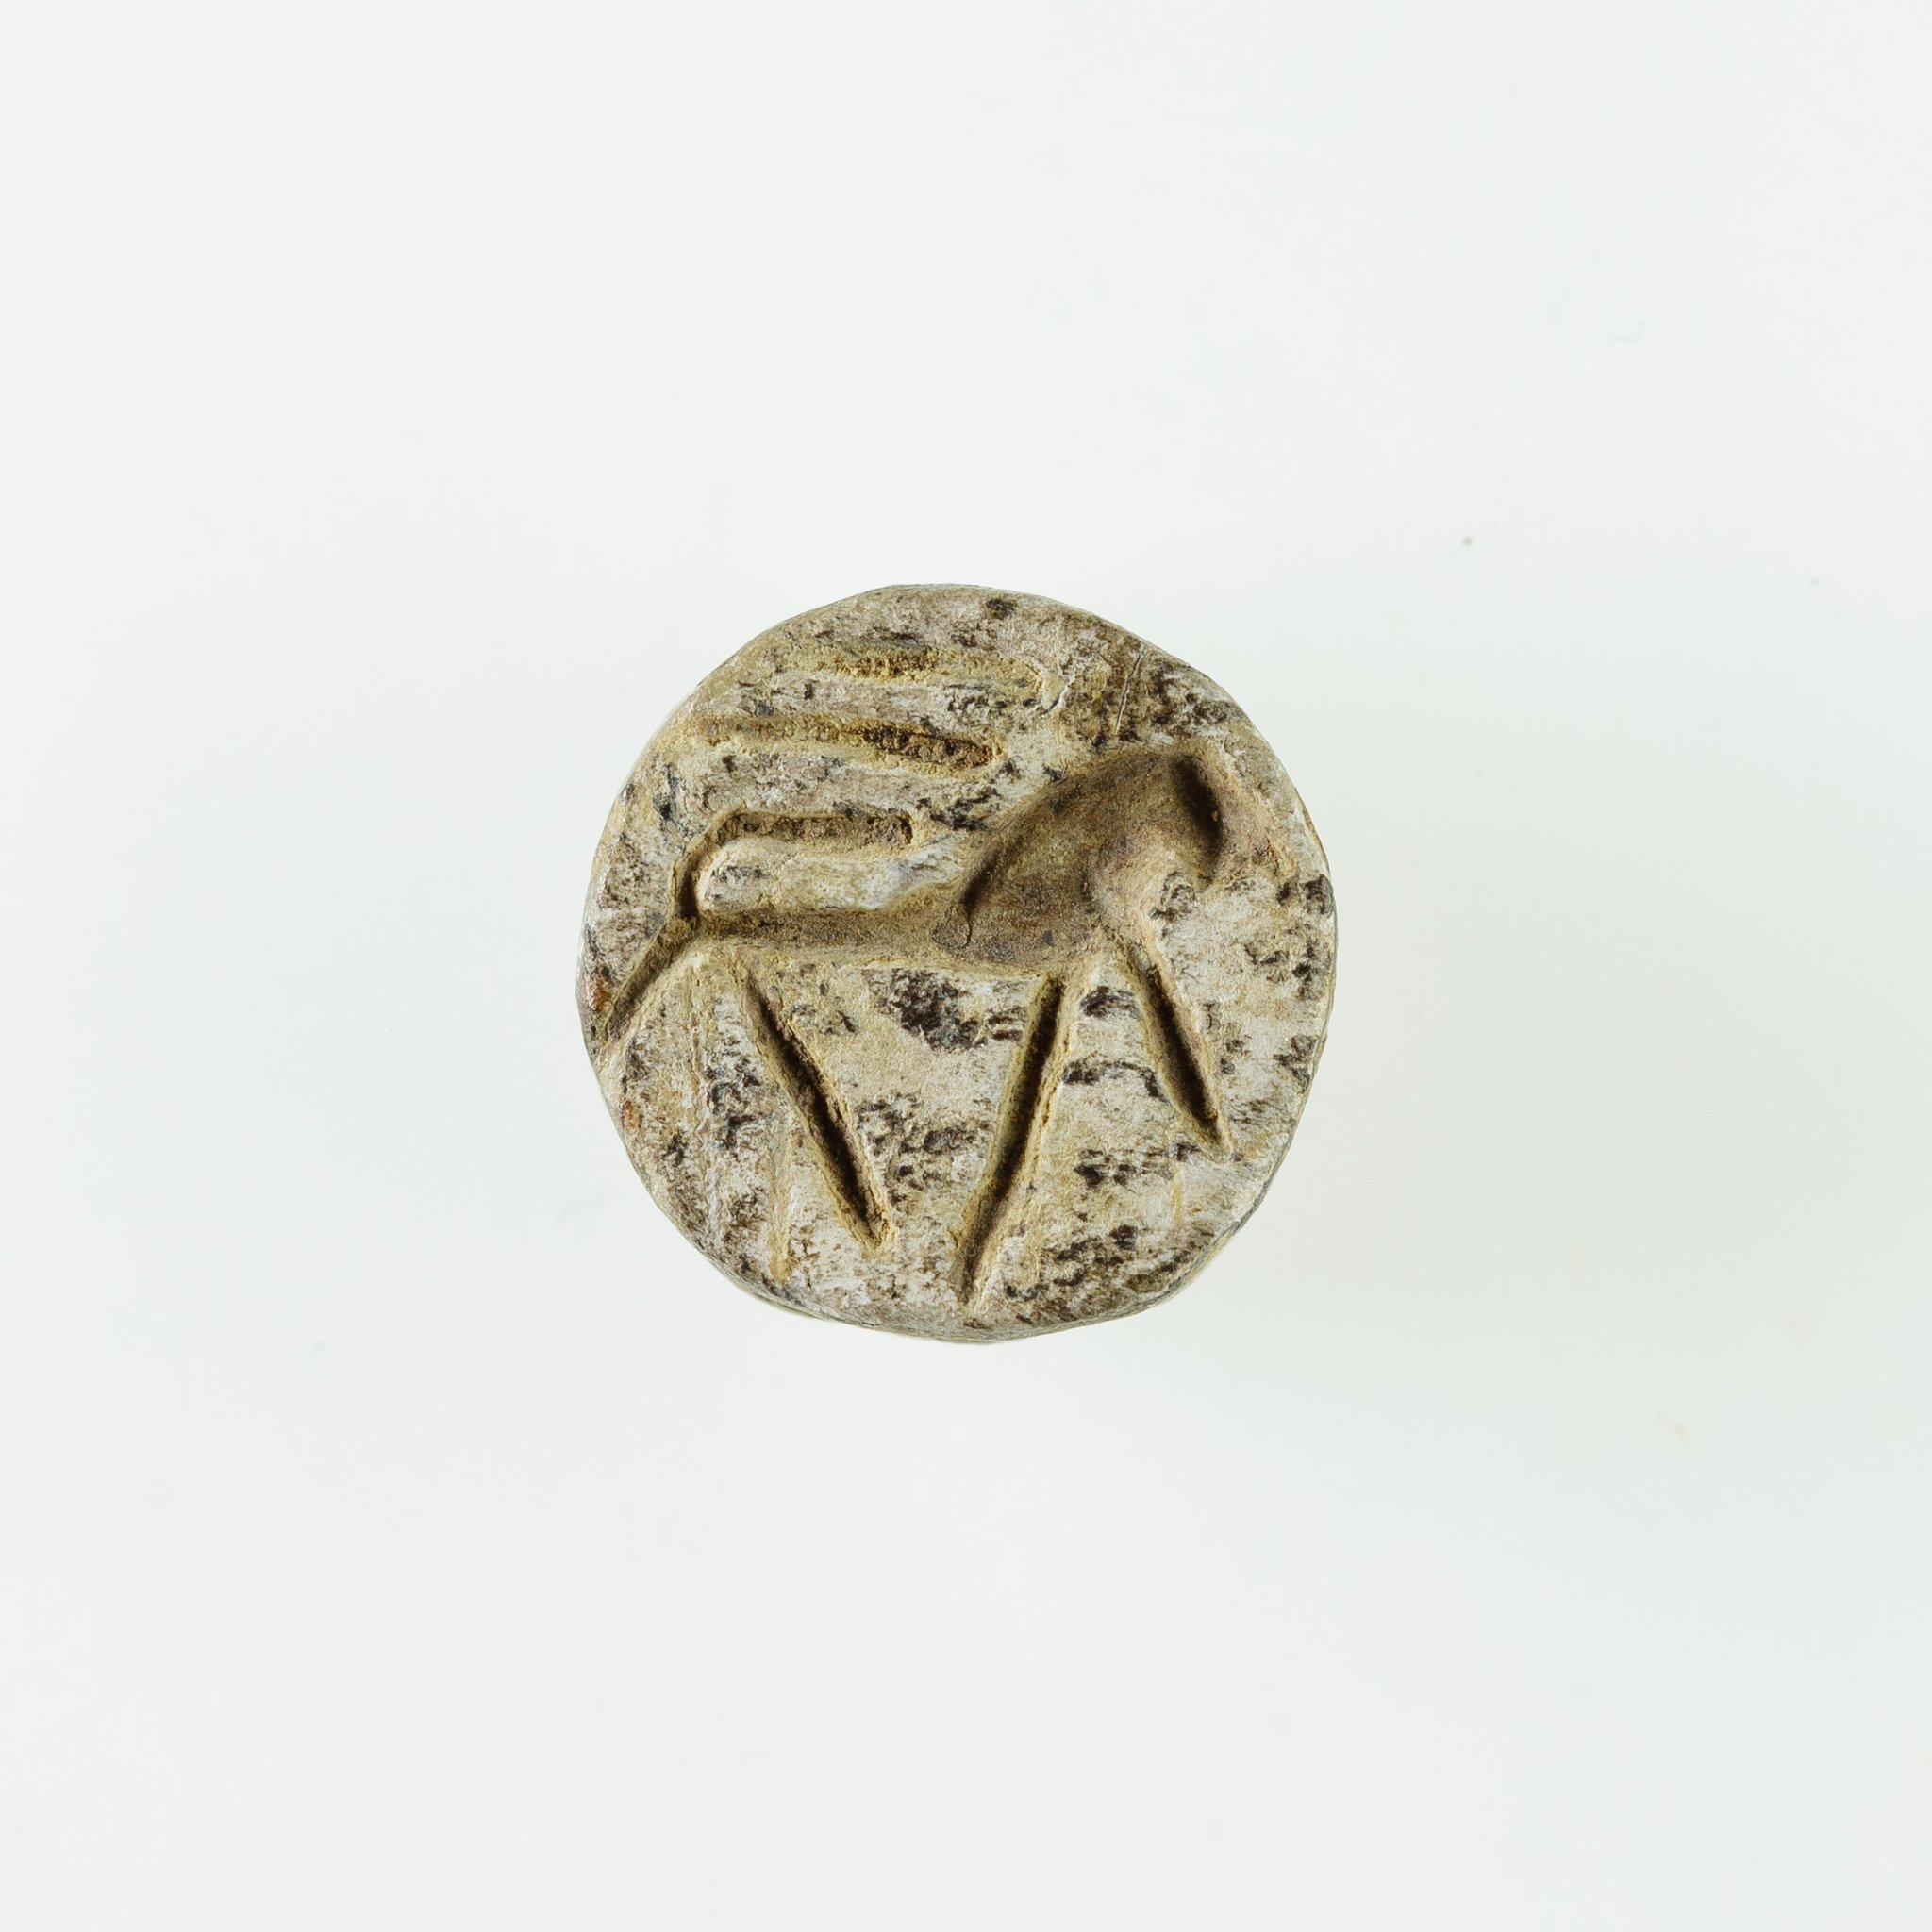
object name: stamp seal, rosette, lion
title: Rosette Stamp Seal with Striding Lion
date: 1186-945 BCE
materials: stone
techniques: glazing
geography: egypt